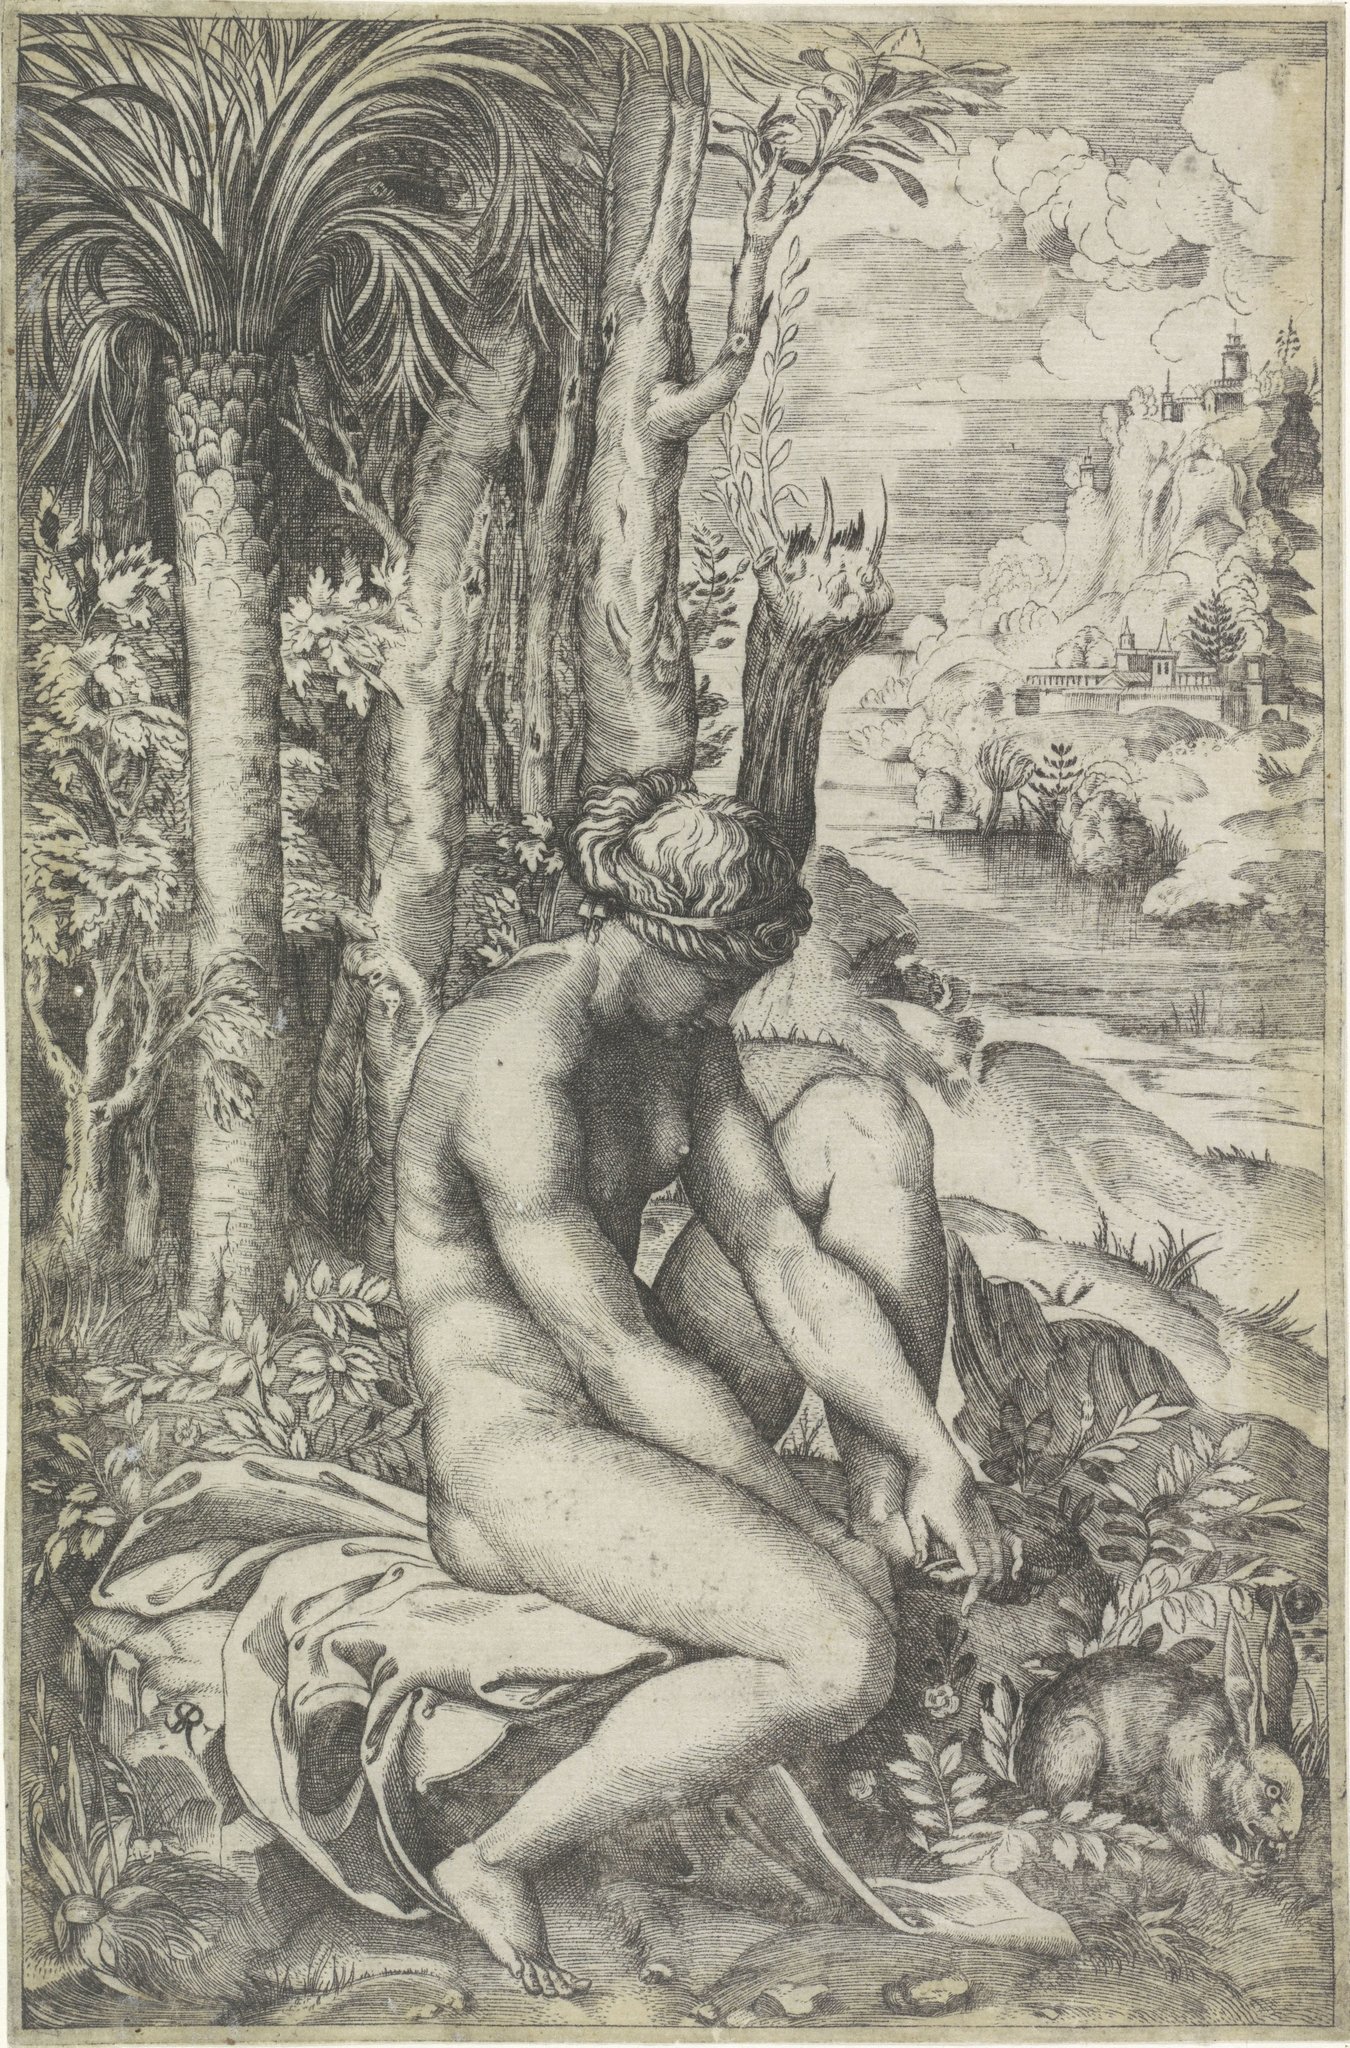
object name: print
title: Venus en de roos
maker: marco dente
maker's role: print maker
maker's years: 1486-1527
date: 1498-1532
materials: paper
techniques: engraving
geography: italy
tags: venus wounded by the thorns of a rose-bush; the roses change from white to red (possibly combined with the story of adonis)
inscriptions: collector's mark: Lugt 2228, collector's mark: Lugt 240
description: Venus zit op een rots in een landschap. Ze haalt een doorn van een rozenstruik uit haar voet. Op de voorgrond rechts een konijn.